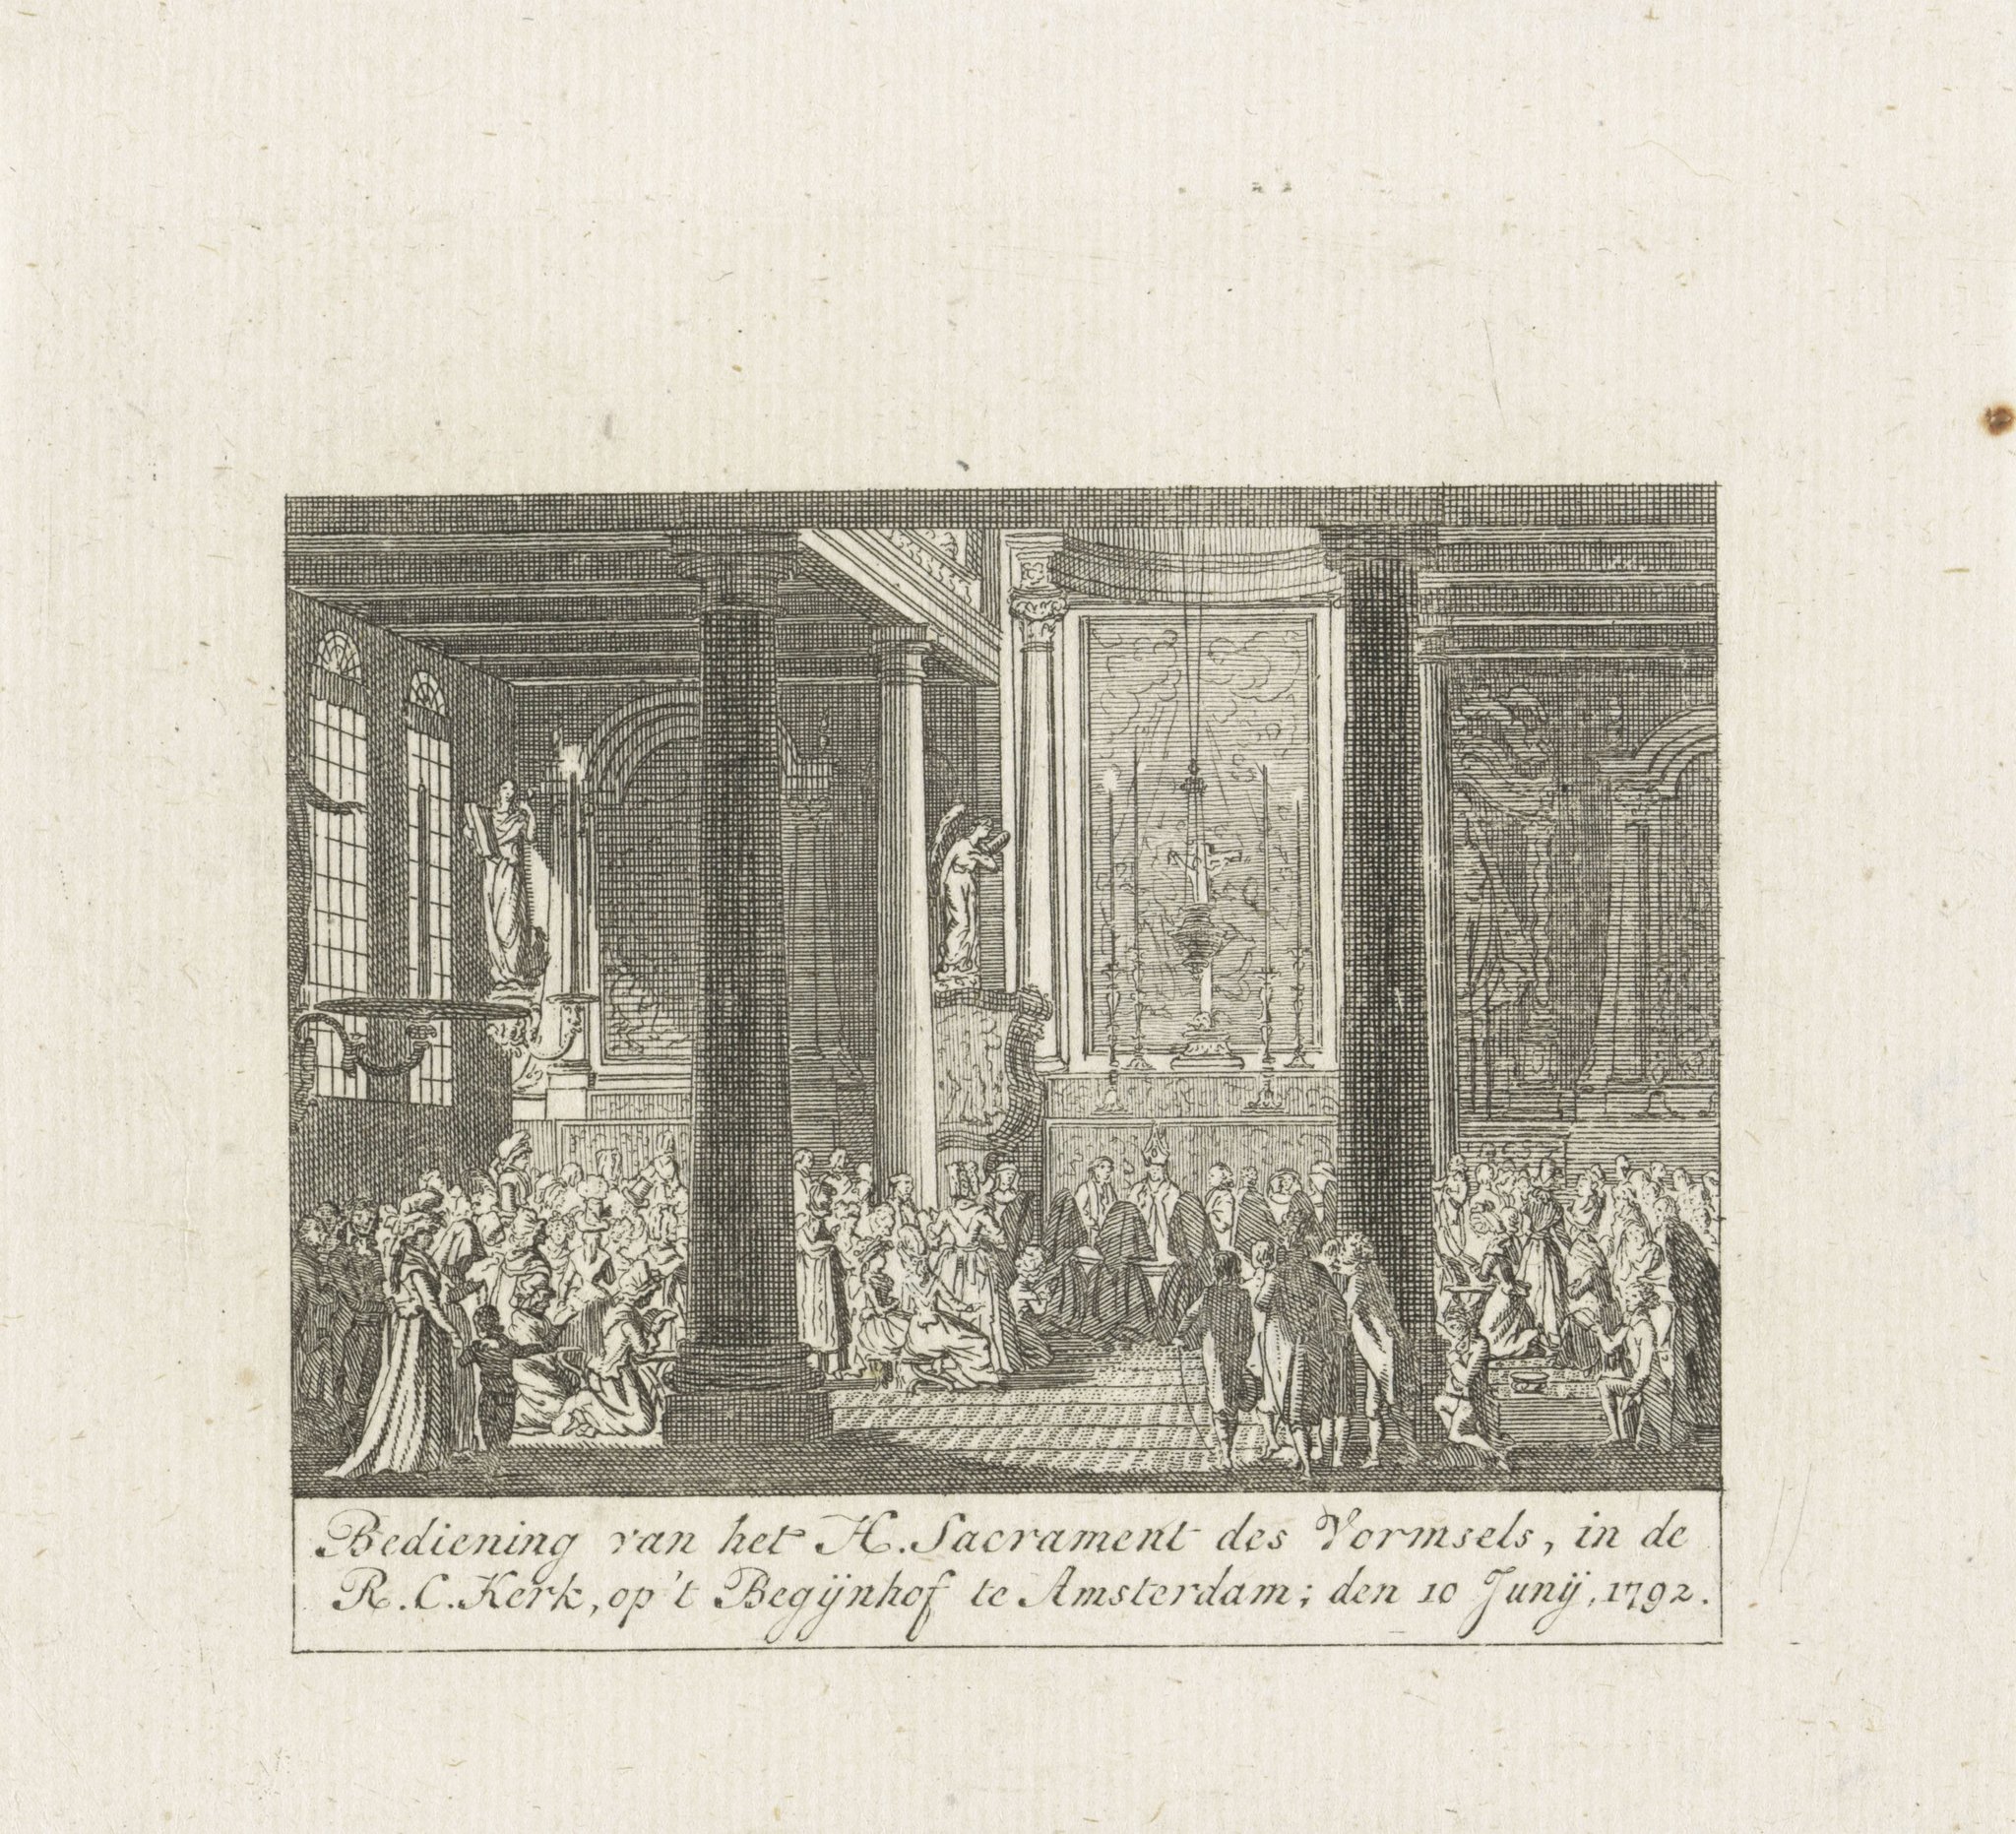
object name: print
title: Toediening van het vormsel in de kerk op het Begijnhof te Amsterdam, 1792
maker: cornelis brouwer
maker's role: print maker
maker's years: 1731-1803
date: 1792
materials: paper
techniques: etching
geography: northern netherlands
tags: rome, confirmation ~ the second of the seven sacraments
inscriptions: collector's mark: Lugt 2228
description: Gebruikt als illustratie in: Arend Fokke Simonsz. De vaderlandsche historie in themata. Amsterdam: Arend Fokke Simonsz., edities tussen 1783-ca. 1792 en in: Nieuwe vaderlandsche almanach, voor het jaar MDCCXCIII, Amsterdam: Arend Fokke Simonsz.